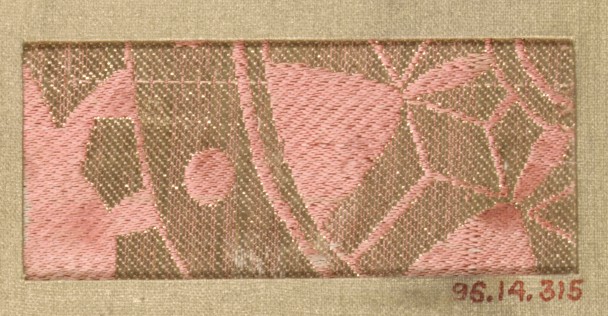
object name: piece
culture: japanese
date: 1701-1900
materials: silk